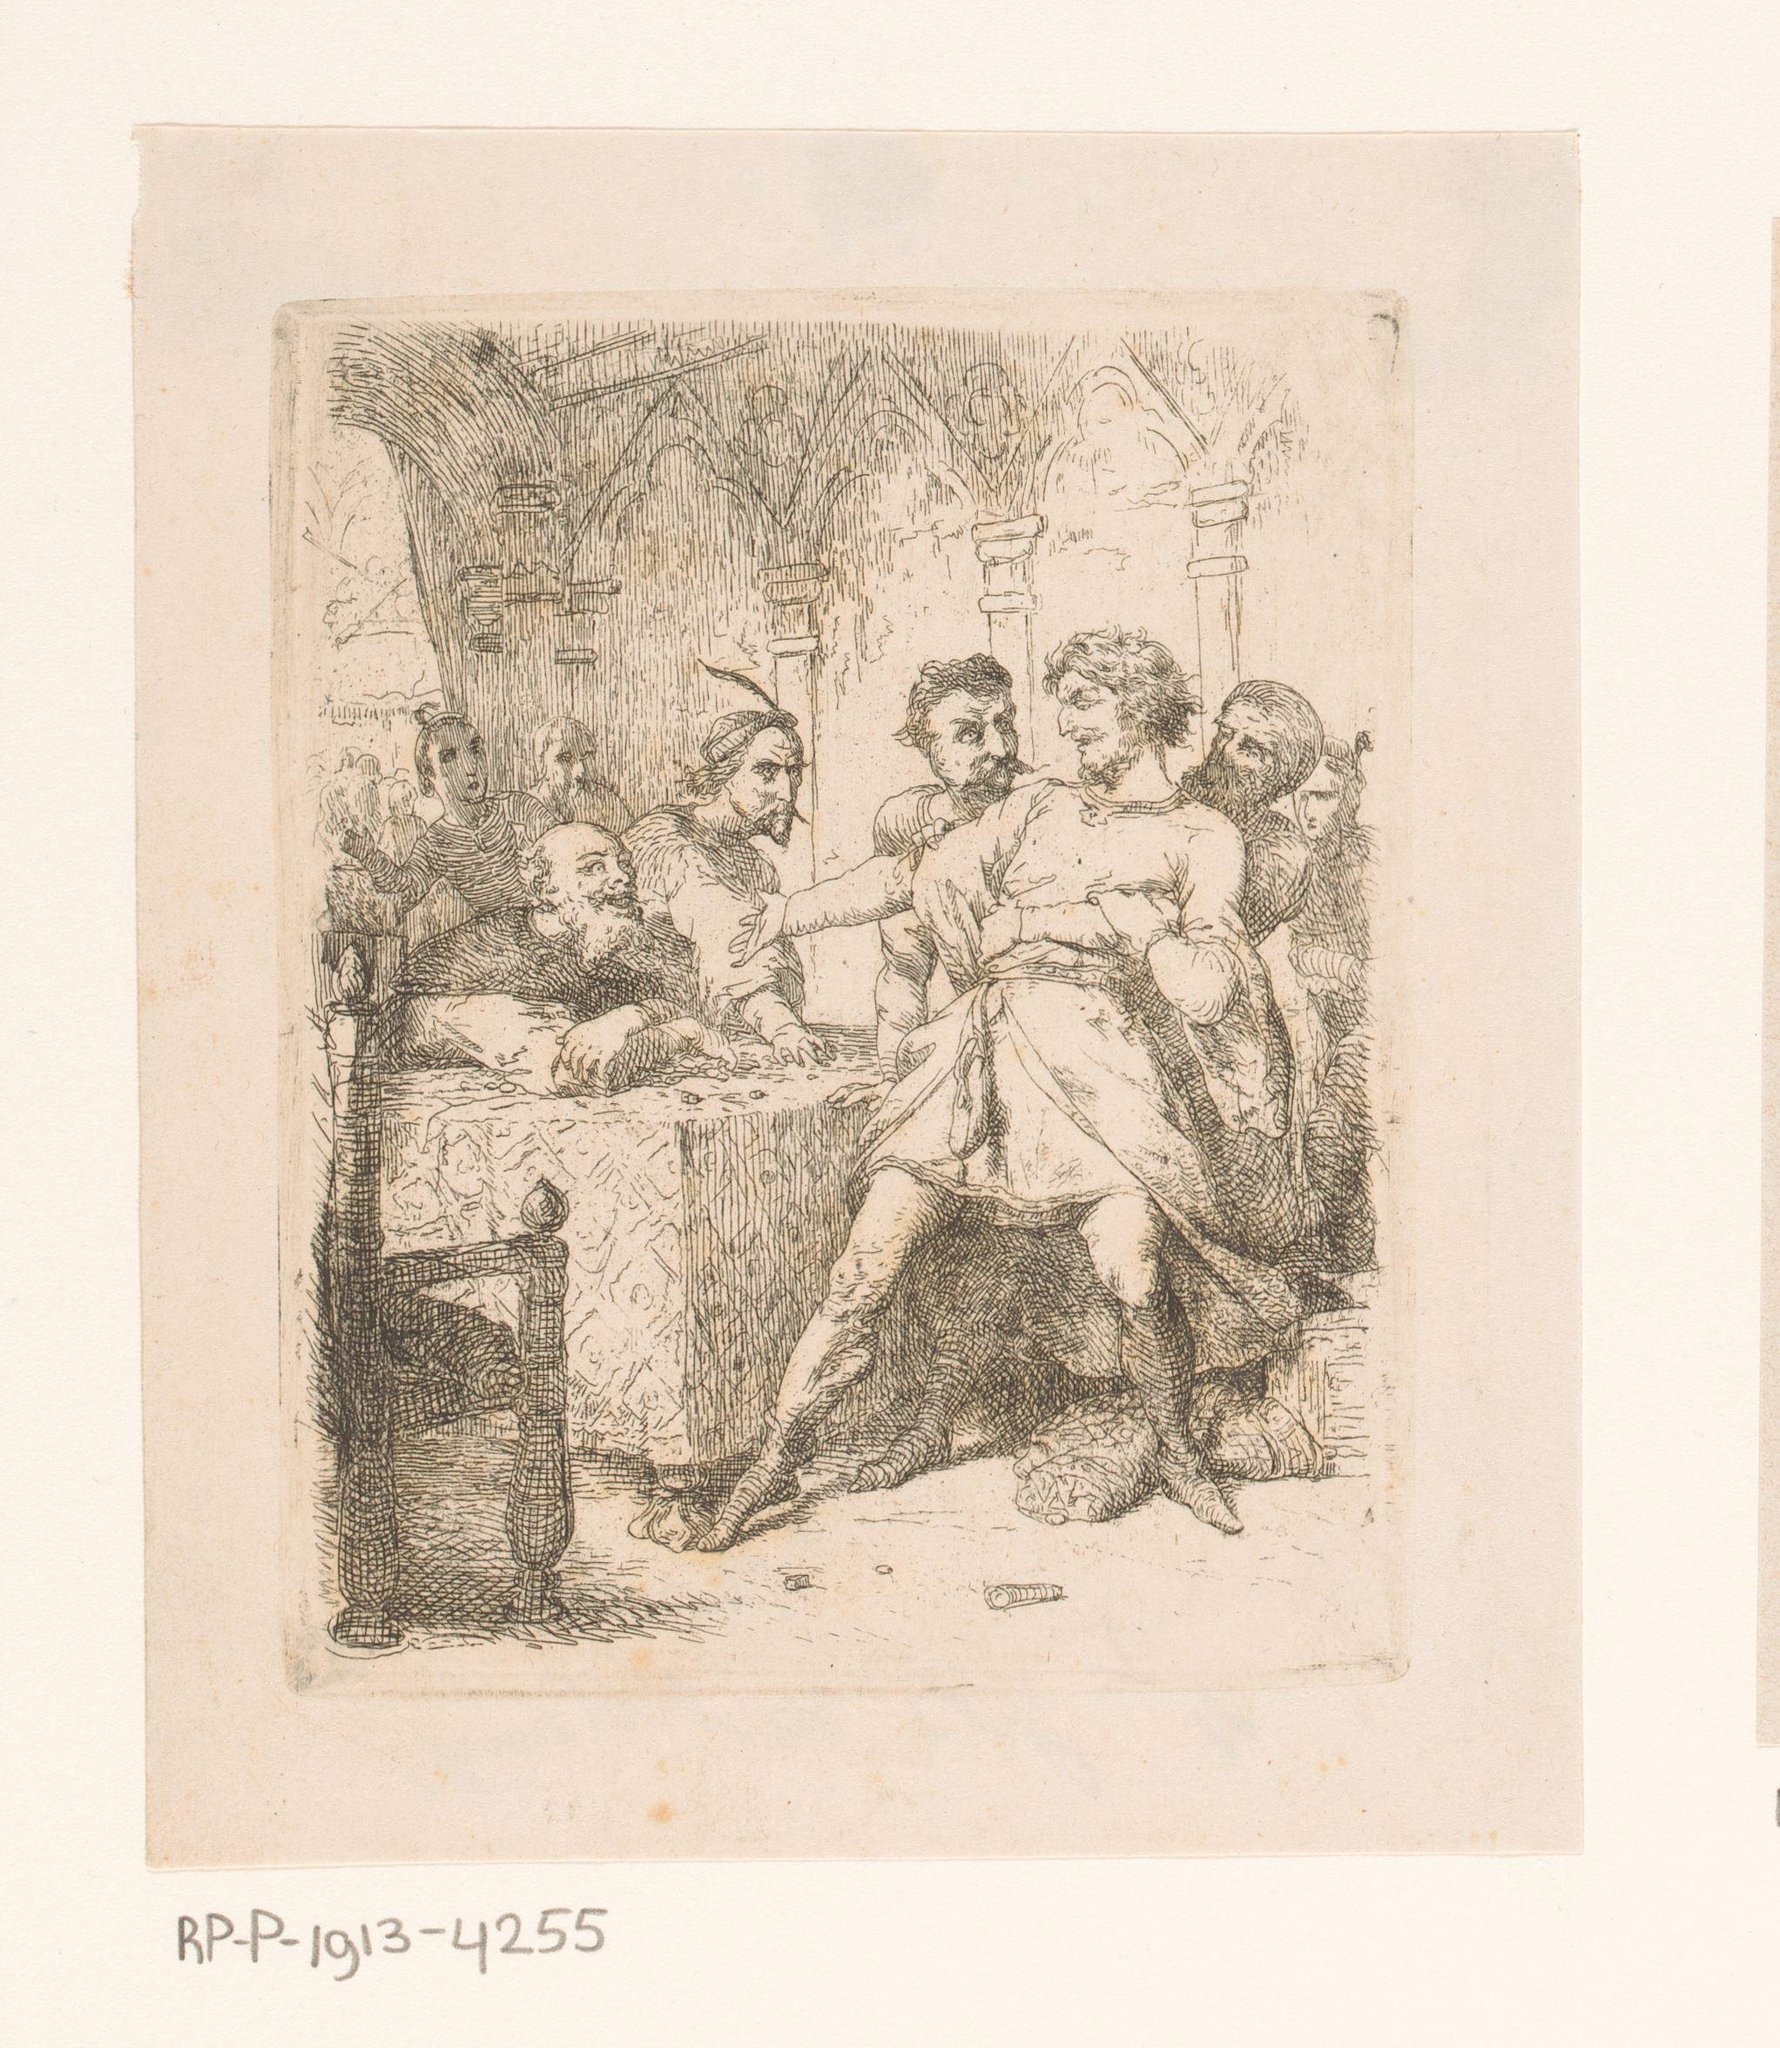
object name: print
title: Bruno aan de dobbeltafel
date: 1857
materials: paper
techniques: etching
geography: amsterdam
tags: dice-games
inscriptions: collector's mark: Lugt 2228, collector's mark: Lugt 1485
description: Prent uit: Horst, J.J. van der. Vader Bruno, de kluizenaar van Overveen. Amsterdam: C.L. van Langenhuysen, 1857.